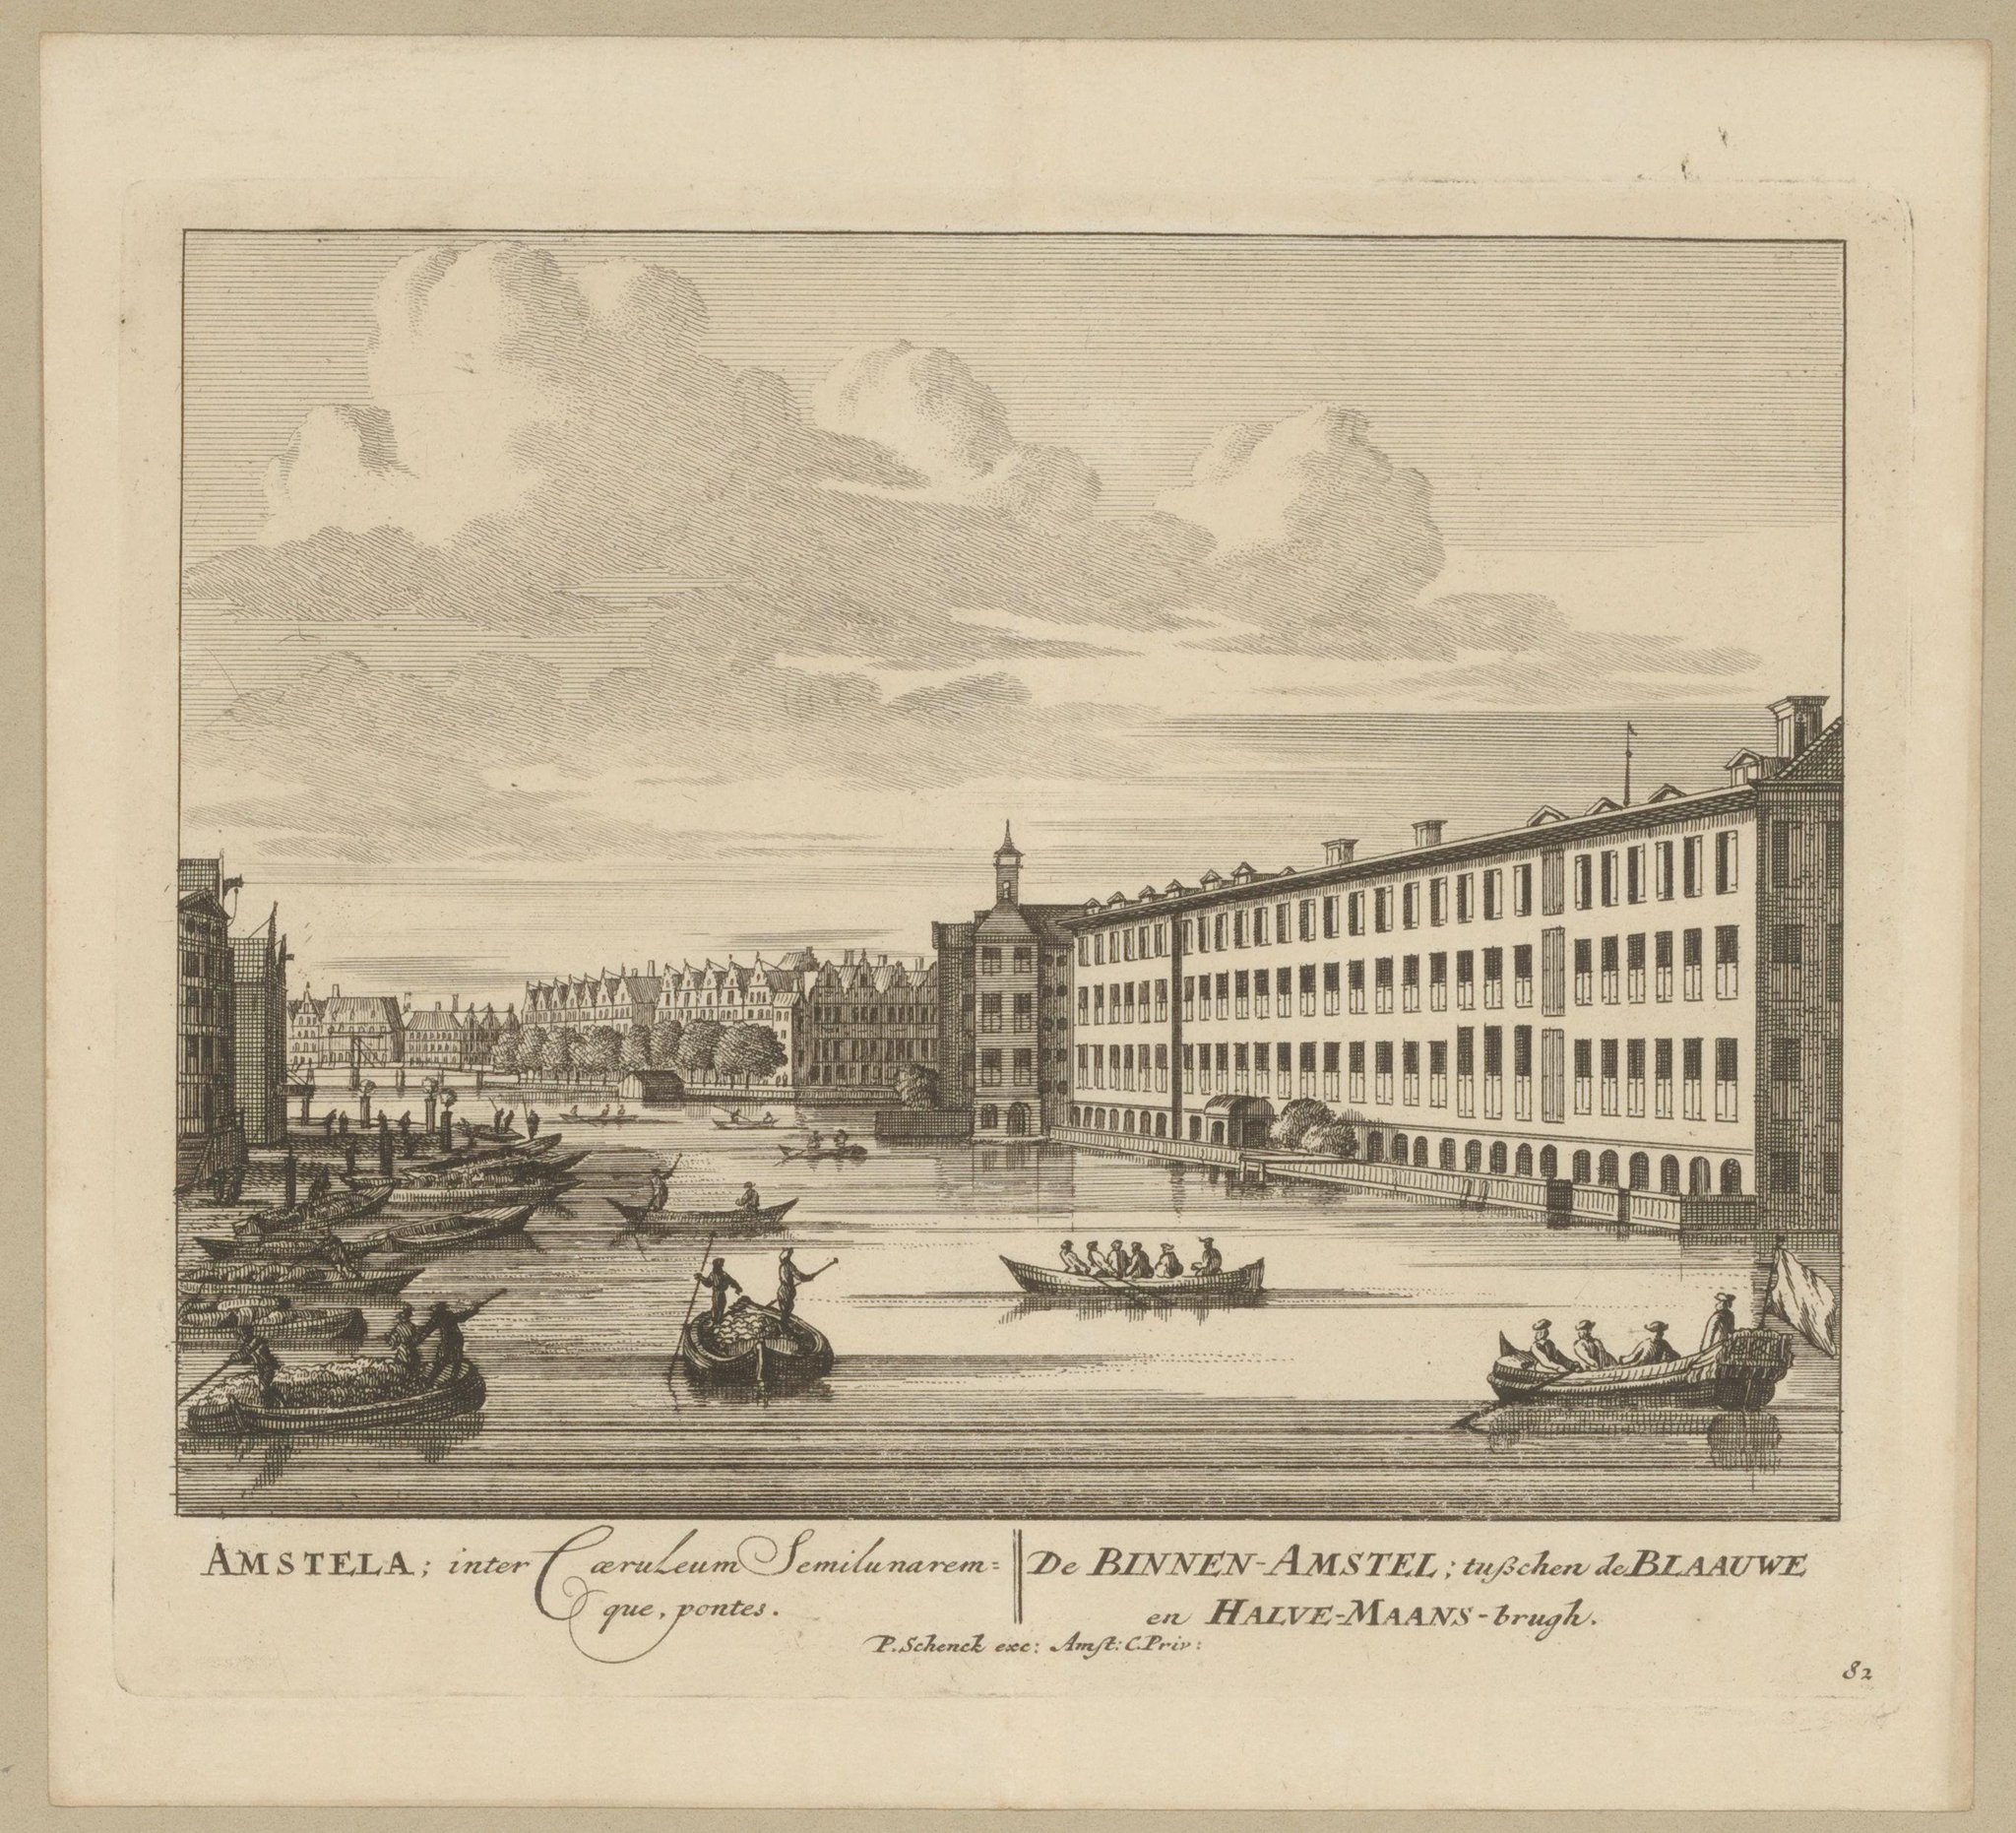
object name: print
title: Gezicht op de Binnen-Amstel tussen de Blauwbrug en de Halvemaansbrug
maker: Anonymous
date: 1710-1711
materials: paper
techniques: etching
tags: city-view in general; 'veduta', canal, bridge in city across river, canal, etc., boat propelled by man or animal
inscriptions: collector's mark: ‘4A no 40 a en b’ Lugt 1641b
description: Huidige staat van prent ook gebruikt in: 100 Afbeeldinge der voornaamste gebouwen van Amsterdam. Amsterdam: Pieter Schenk (I), s.a. [1710-1711]. En in: 100 Afbeeldinge der voornaamste gebouwen van Amsterdam. Amsterdam: Barent Greve, s.a. [1757-1766].* *In de tweede uitgave, uitgegeven door Barent Greve, is alleen de titelprent aangepast. De overige prenten zijn onveranderd gebleven.